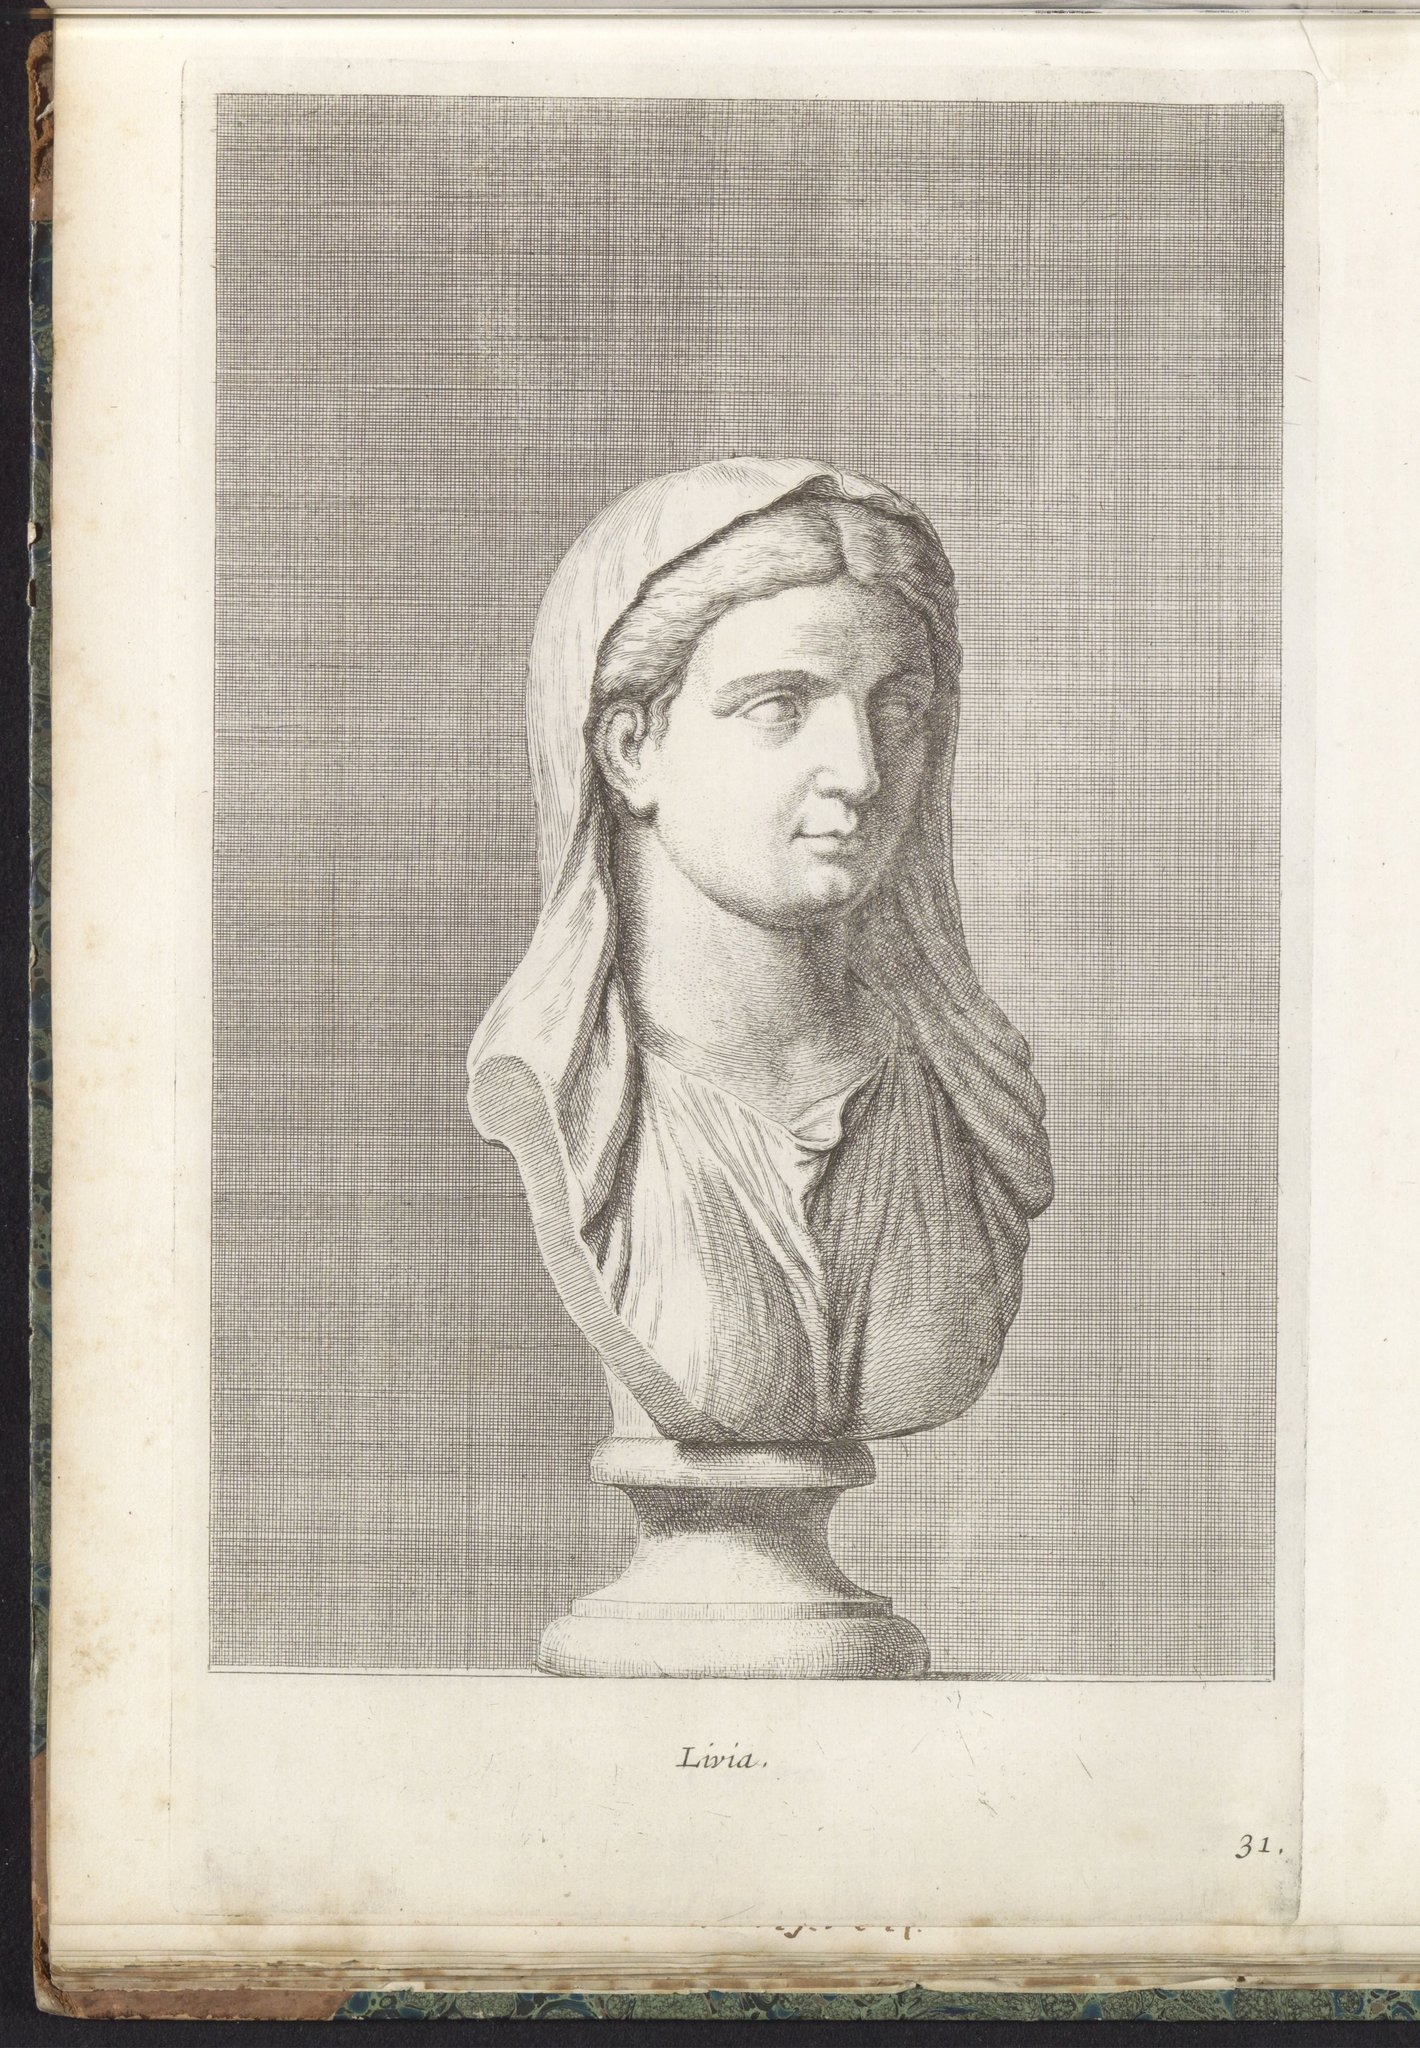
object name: print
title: Livia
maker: hubert quellinus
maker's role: print maker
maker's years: 1619-1687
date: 1646-1670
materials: paper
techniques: engraving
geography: antwerp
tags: piece of sculpture, reproduction of a piece of sculpture, female persons from classical history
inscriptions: number: ‘55’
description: Klassieke buste van een vrouw, naar rechts gedraaid. Ze draagt een sluier. De prent maakt deel uit van een album met een serie prenten naar de sculpturen in de verzameling van Gerard Reynst.